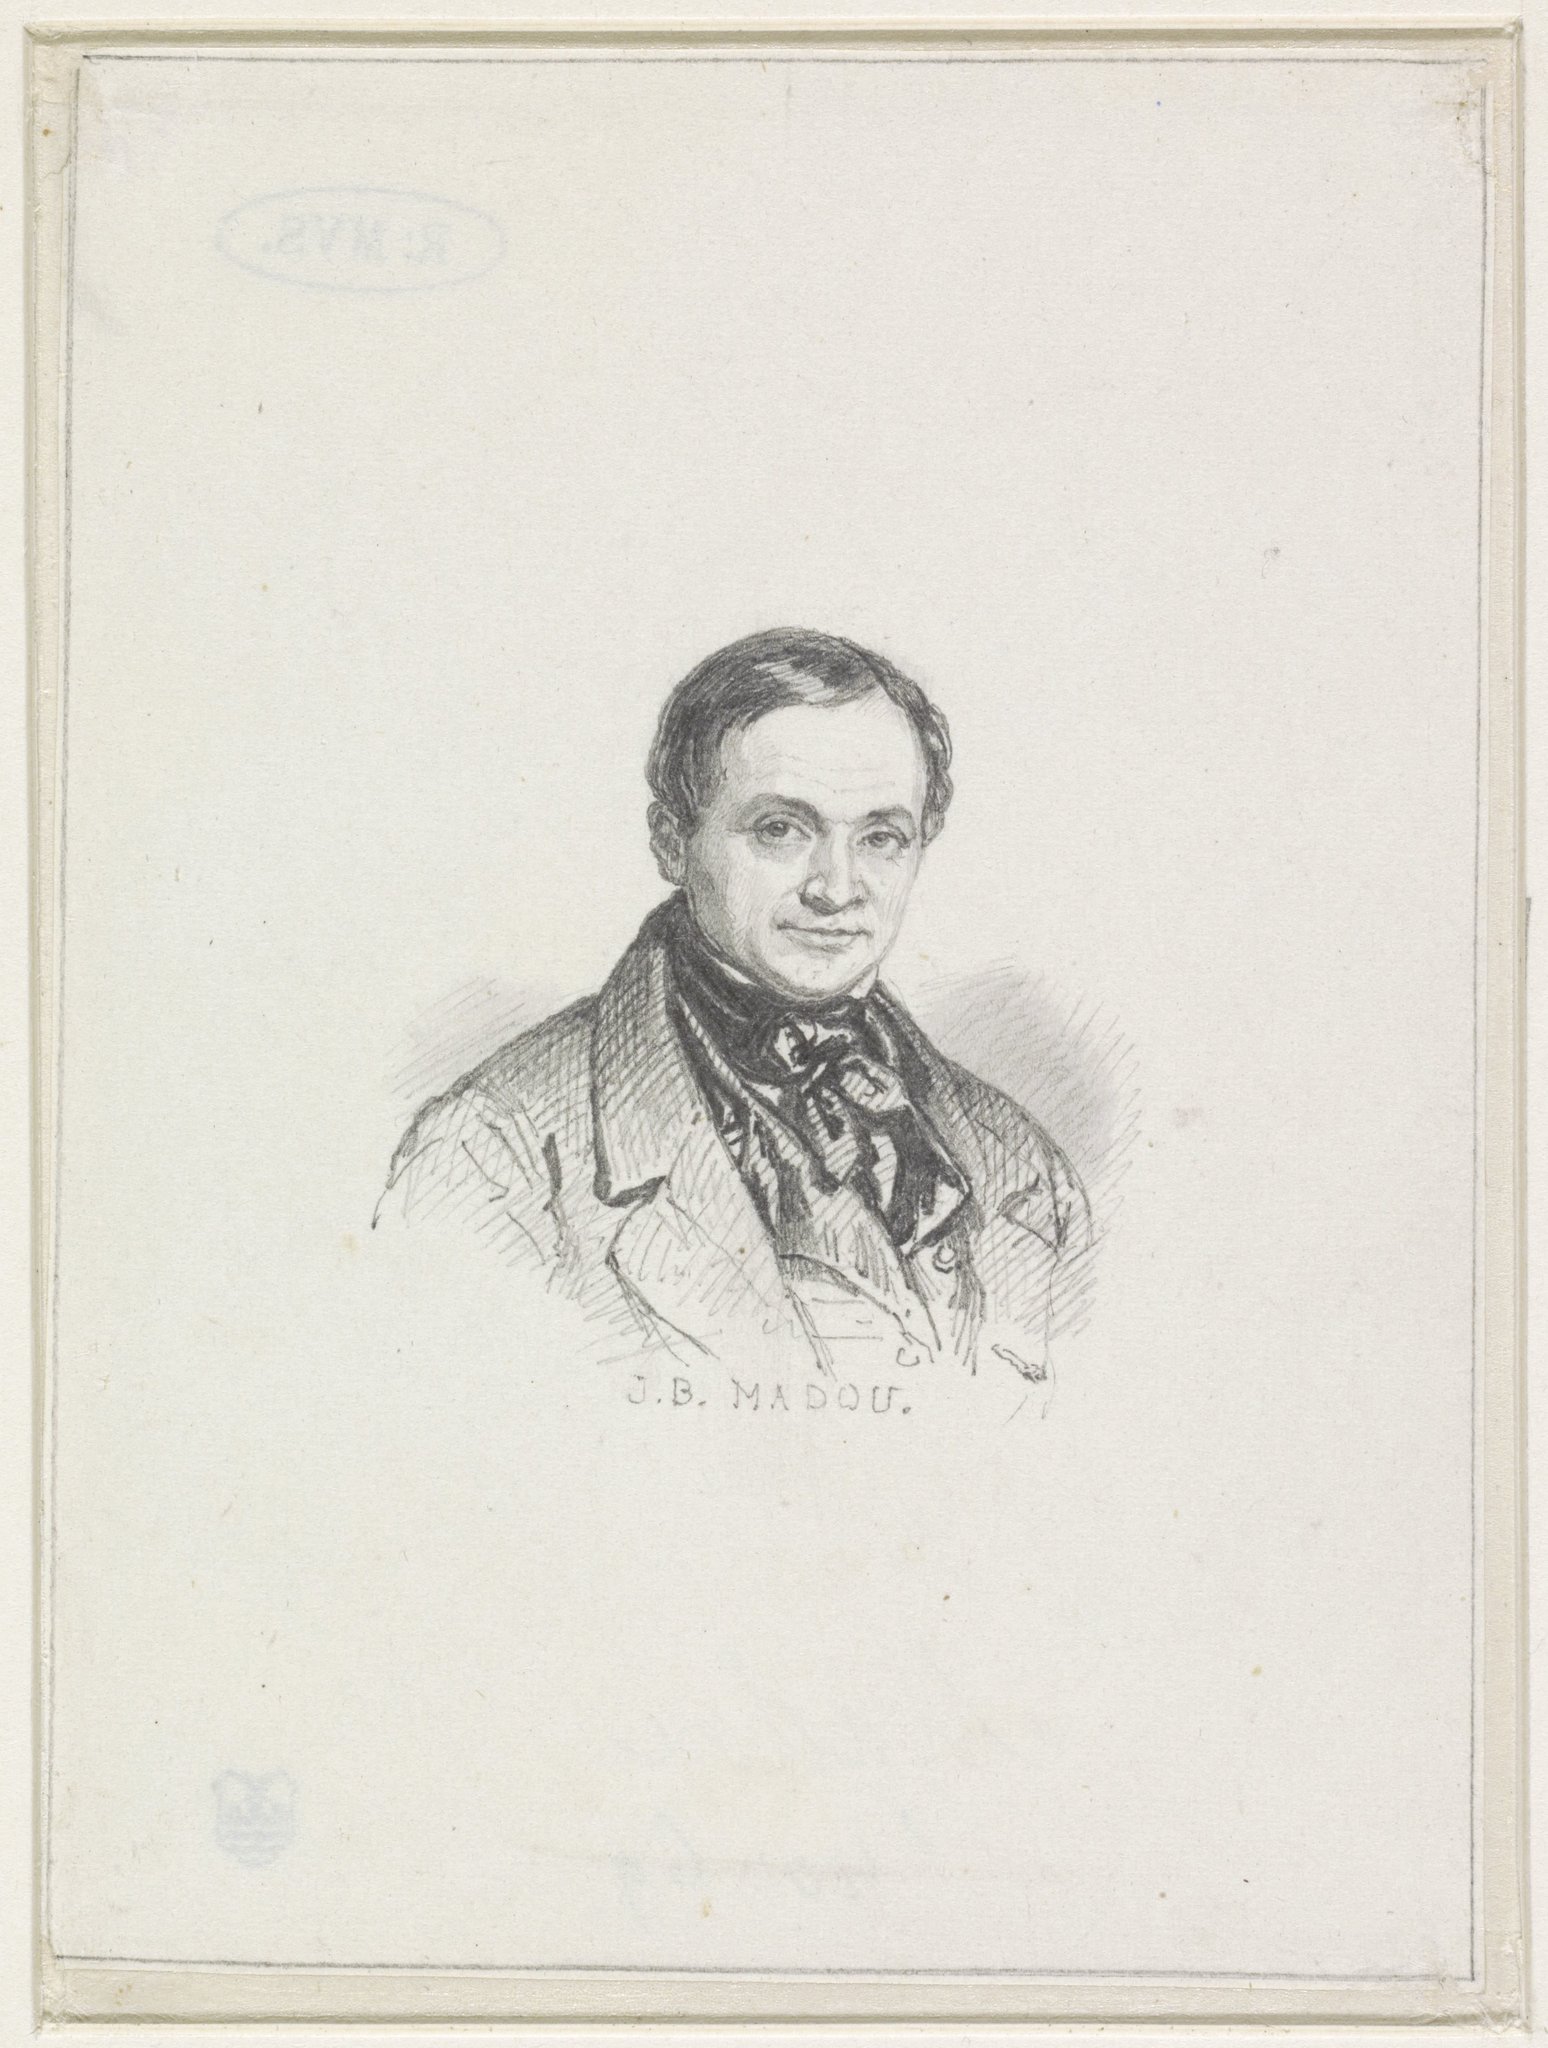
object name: drawing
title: Zelfportret van Jean Baptiste Madou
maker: jean baptiste madou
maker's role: draughtsman, painter, print maker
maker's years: 1796-1877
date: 1806-1877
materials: paper, pencil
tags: brussels, draughtsman, jean baptiste madou, historical persons, portrait, self-portrait of artist